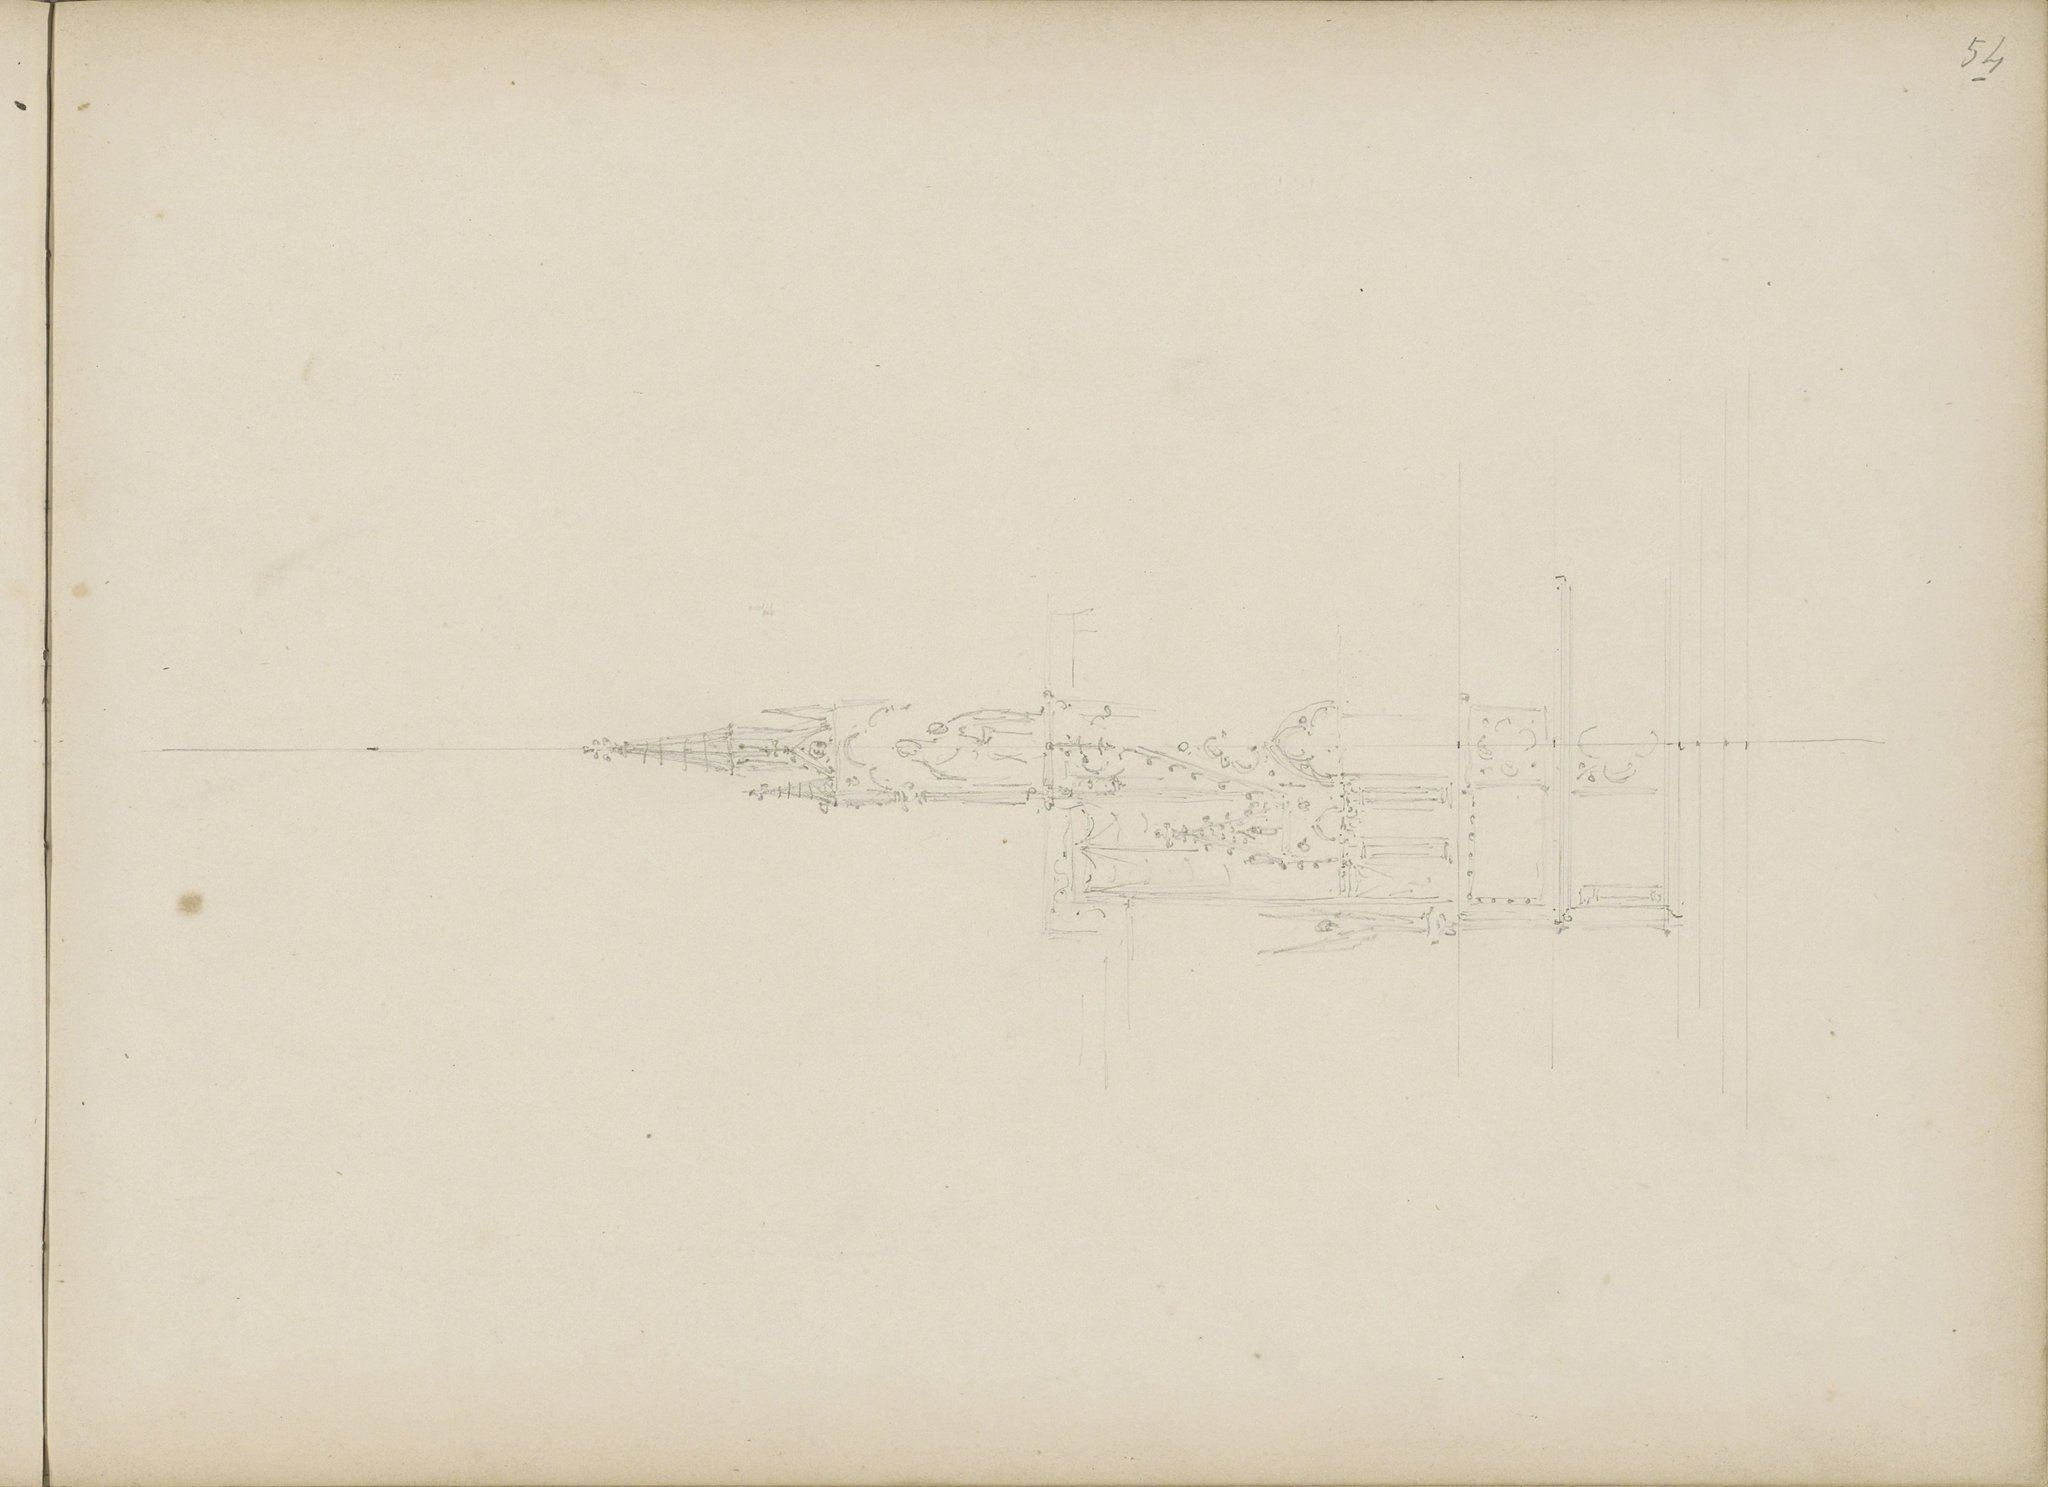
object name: sketchbook leaf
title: Altaar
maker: pierre joseph hubert cuypers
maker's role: draughtsman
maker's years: 1827-1921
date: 1857-1859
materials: paper, pencil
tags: altar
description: Blad 54 recto uit een schetsboek met 77 bladen.